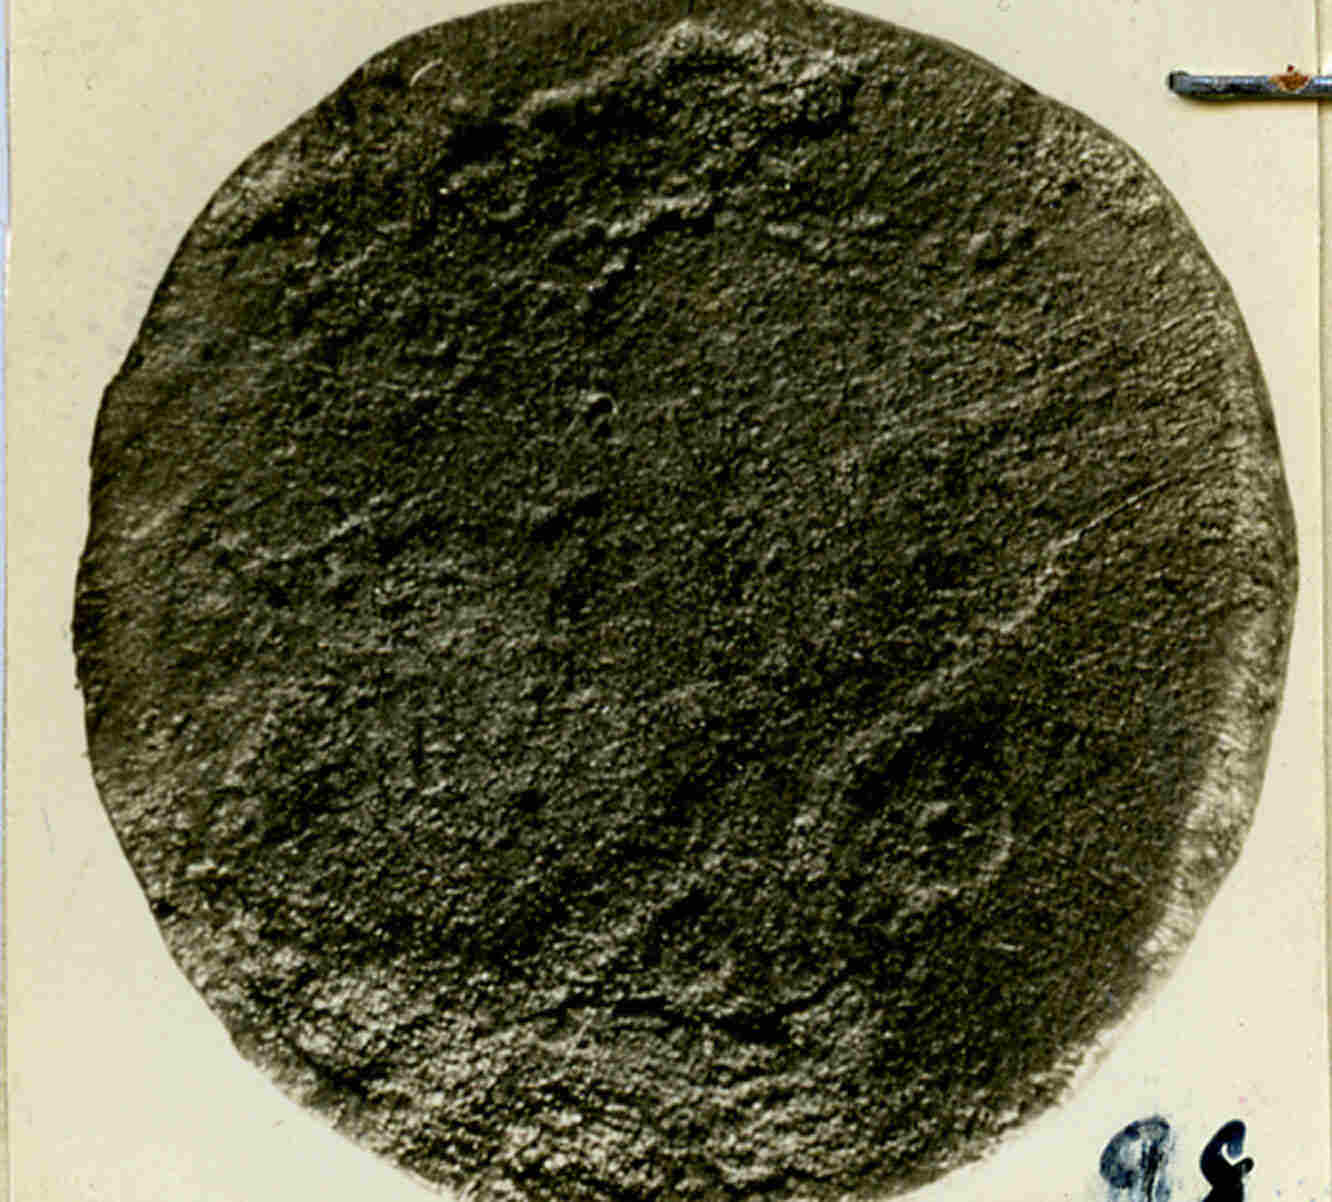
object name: coin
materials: copper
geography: iran